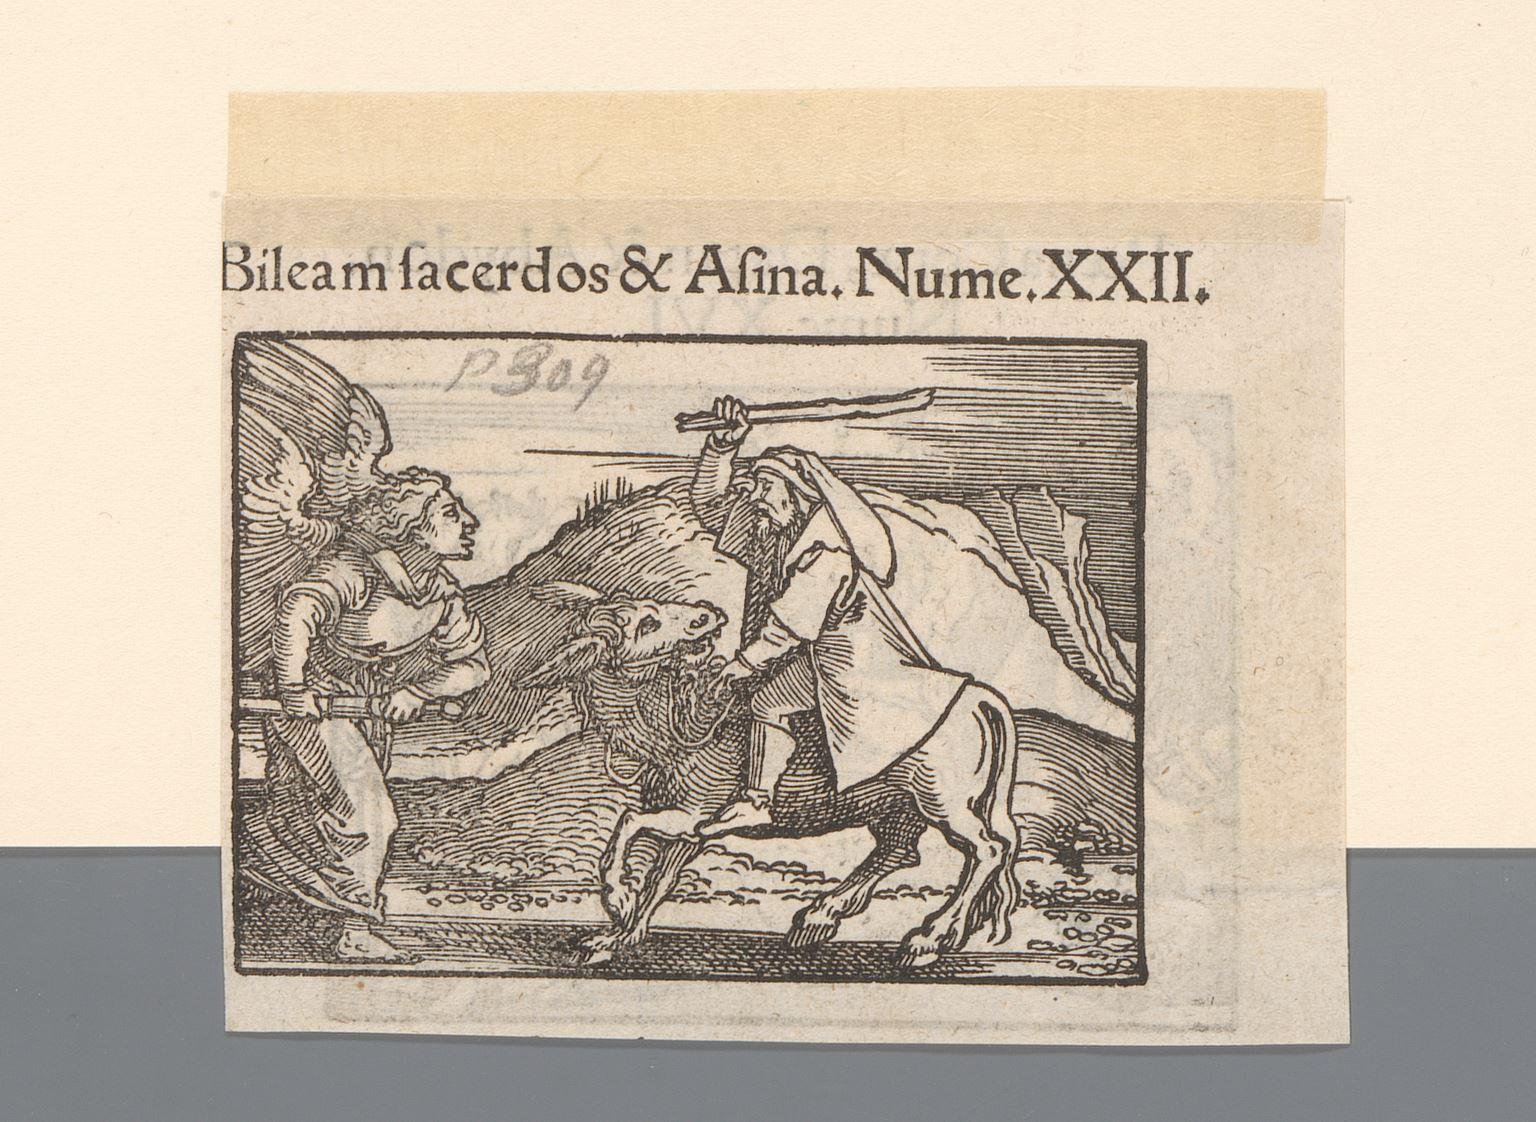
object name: print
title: Bileam sacerdos & Asina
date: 1530-1533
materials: paper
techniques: woodcut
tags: balaam saddles his donkey and departs with the moabite messengers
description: Prent afkomstig uit: Biblicae historiae. Frankfurt am Main: Egenloph, 1539.